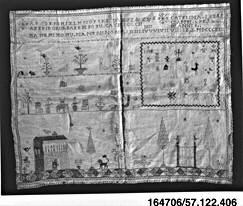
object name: sampler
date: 1813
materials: linen, silk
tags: animals,houses